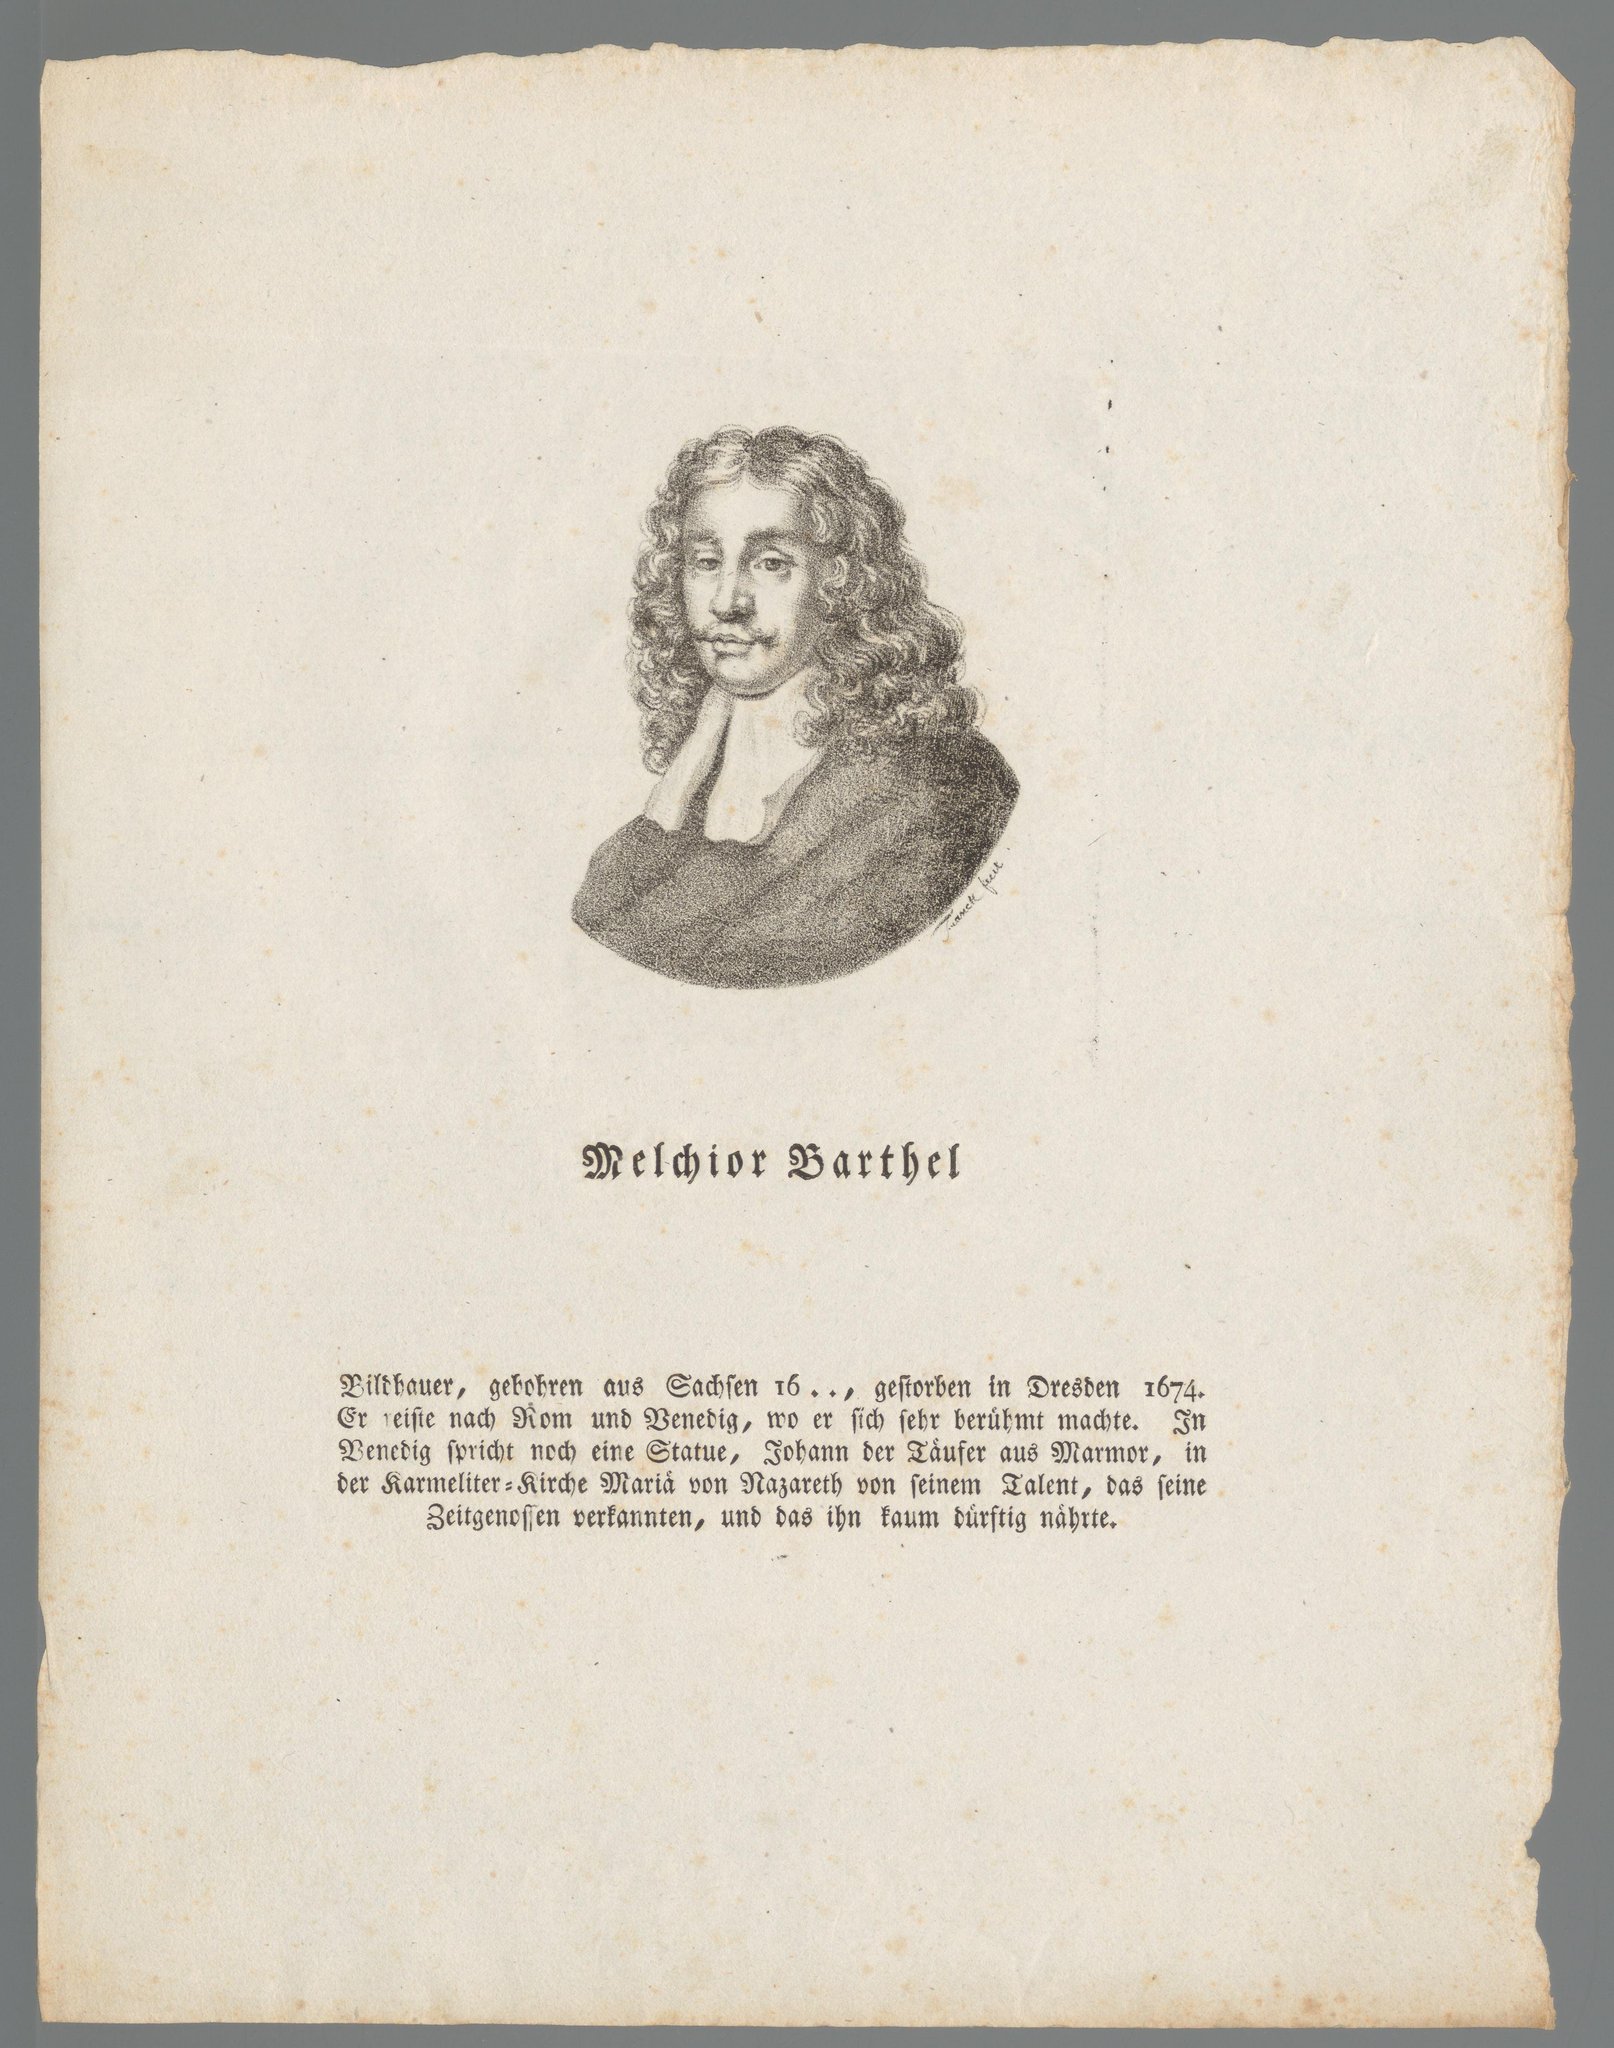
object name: print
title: Melchior Barthel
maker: maximilian franck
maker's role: print maker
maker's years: 1780-1830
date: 1813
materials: paper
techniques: letterpress printing, lithograph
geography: munich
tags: portrait, self-portrait of sculptor, historical persons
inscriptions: collector's mark: Lugt 2228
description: Prent uit: Lindauer, Joseph. Deutsche Künstler-Gallerie. München: Maximilian Franck, 1813.